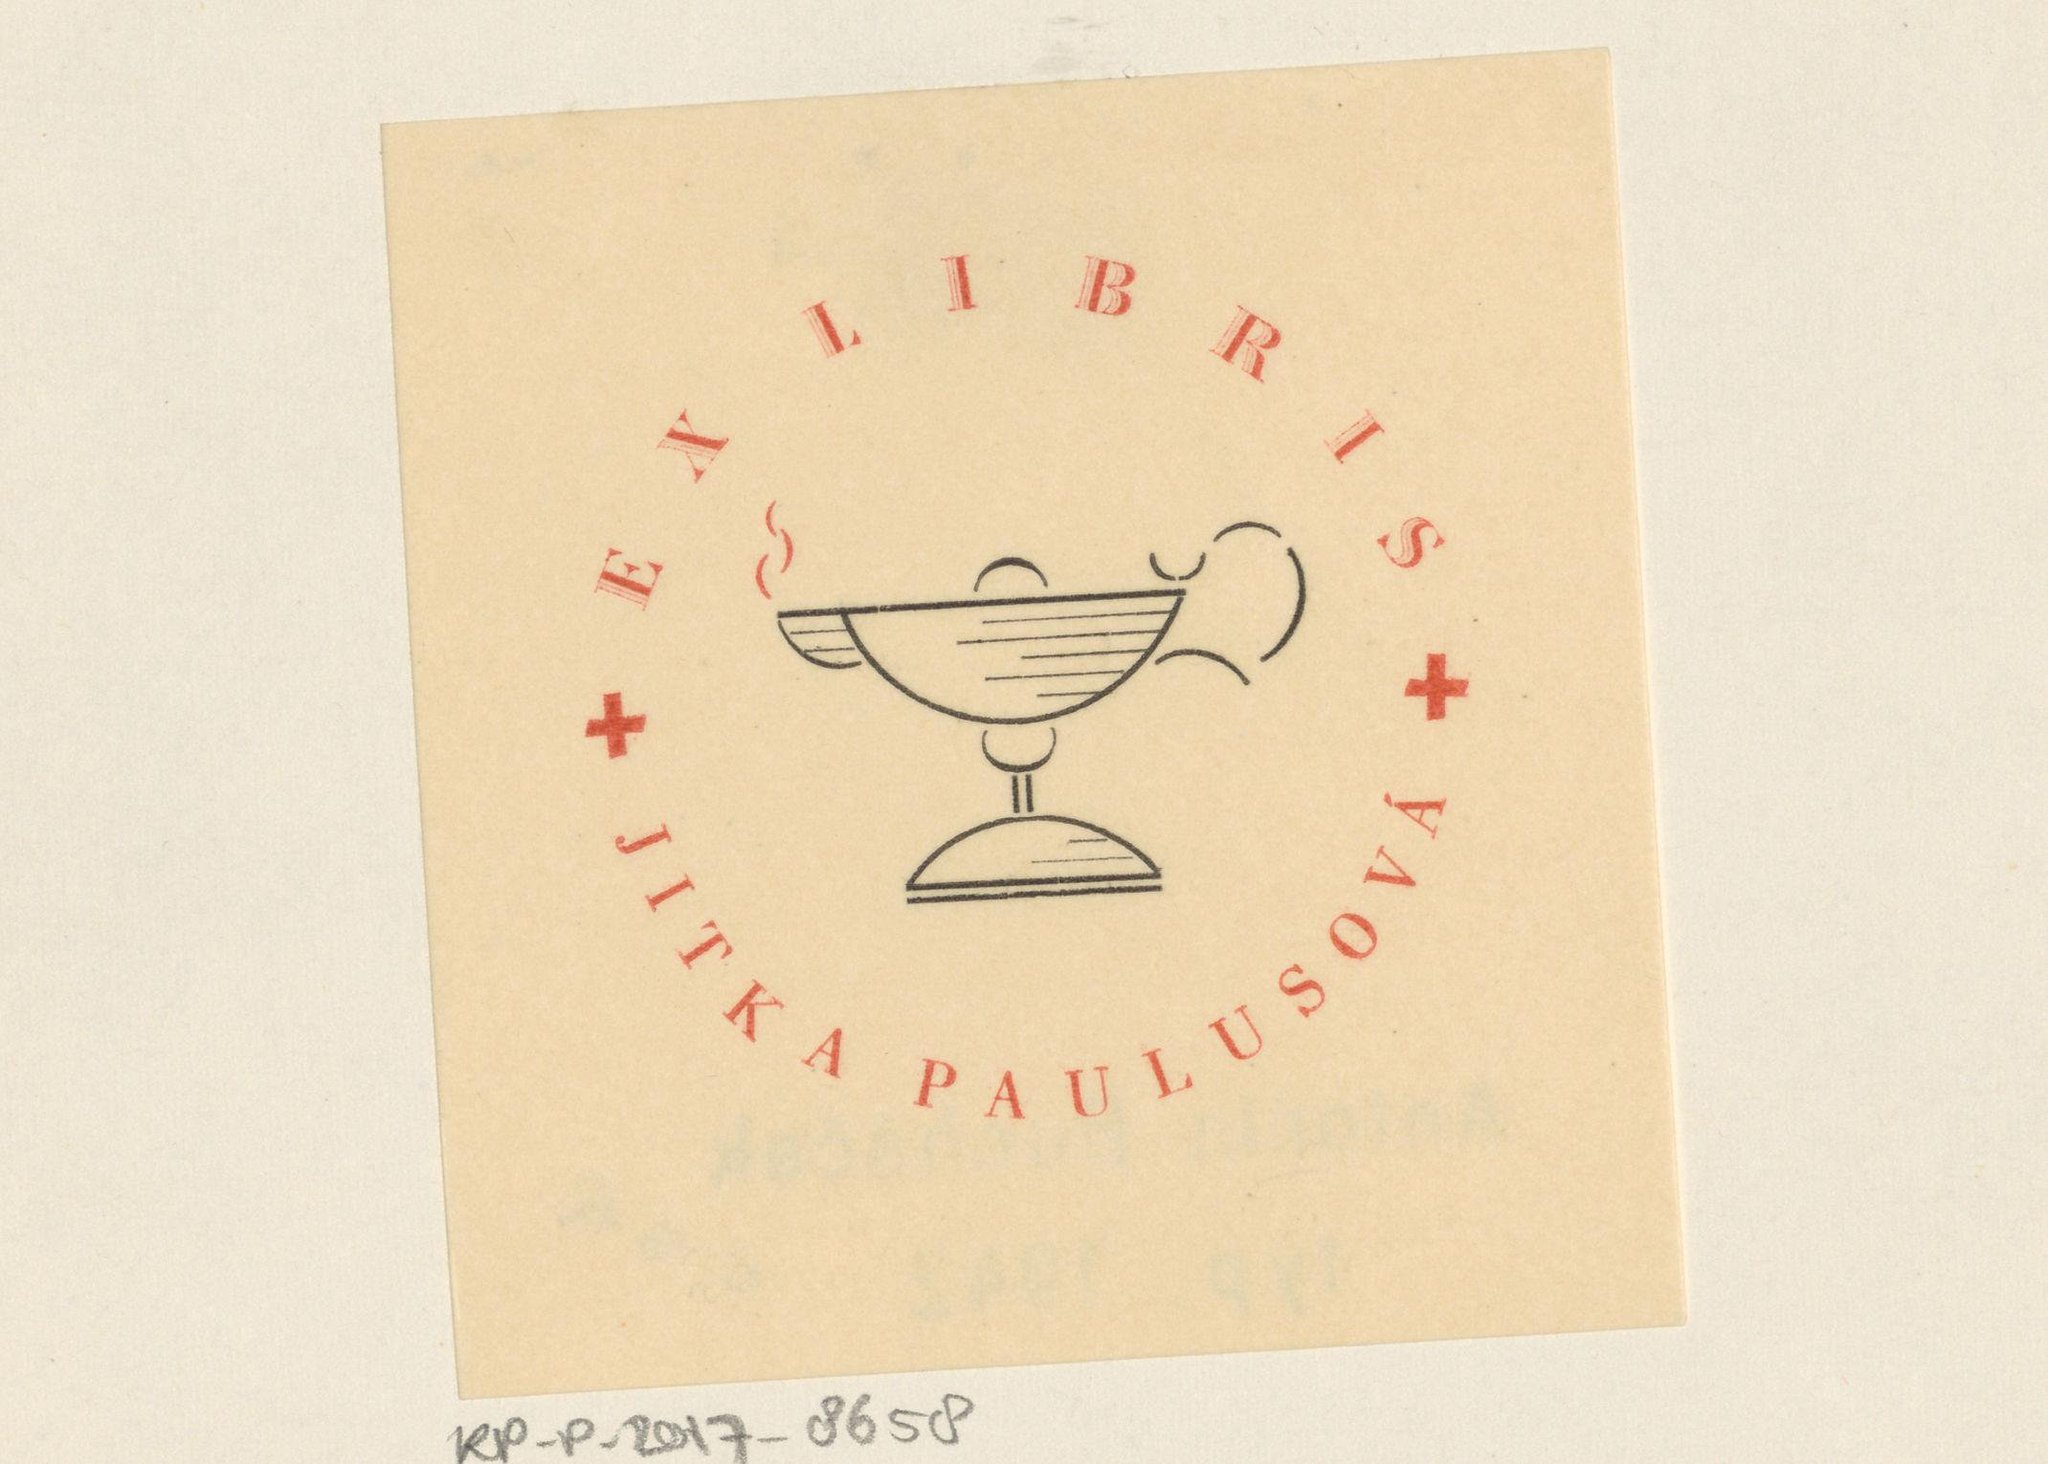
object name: bookplate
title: Ex libris van Jitka Paulusová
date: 1942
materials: paper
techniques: printing block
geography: czech republic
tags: oil-lamp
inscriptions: workshop stamp: ‘Antonin Buchacek/ typ. 1942’